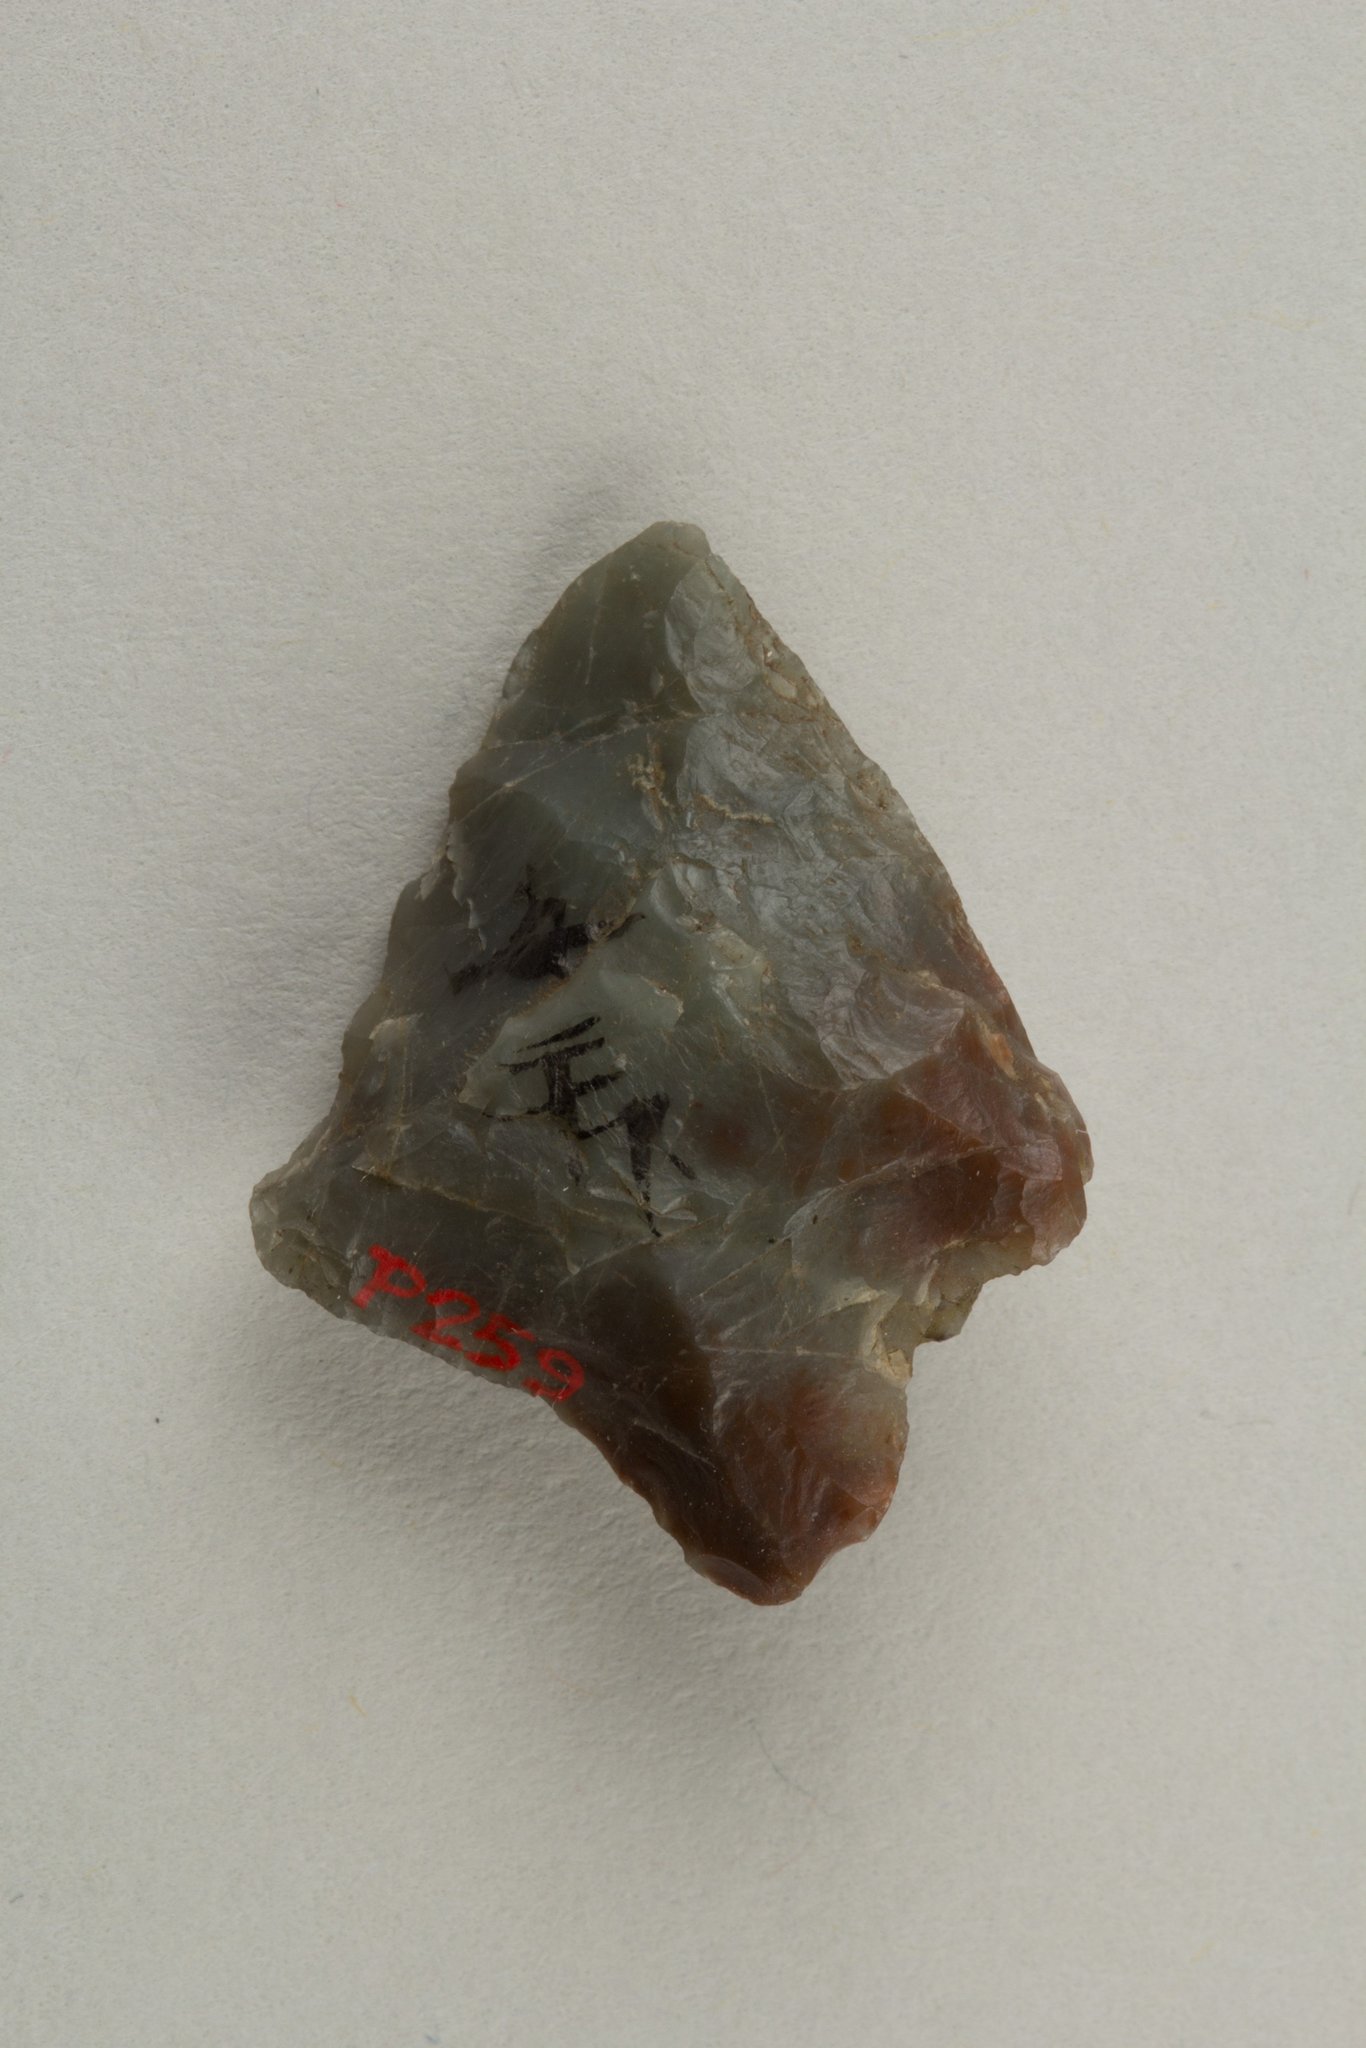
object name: arrowhead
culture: japanese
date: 1500-1000 BCE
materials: stone